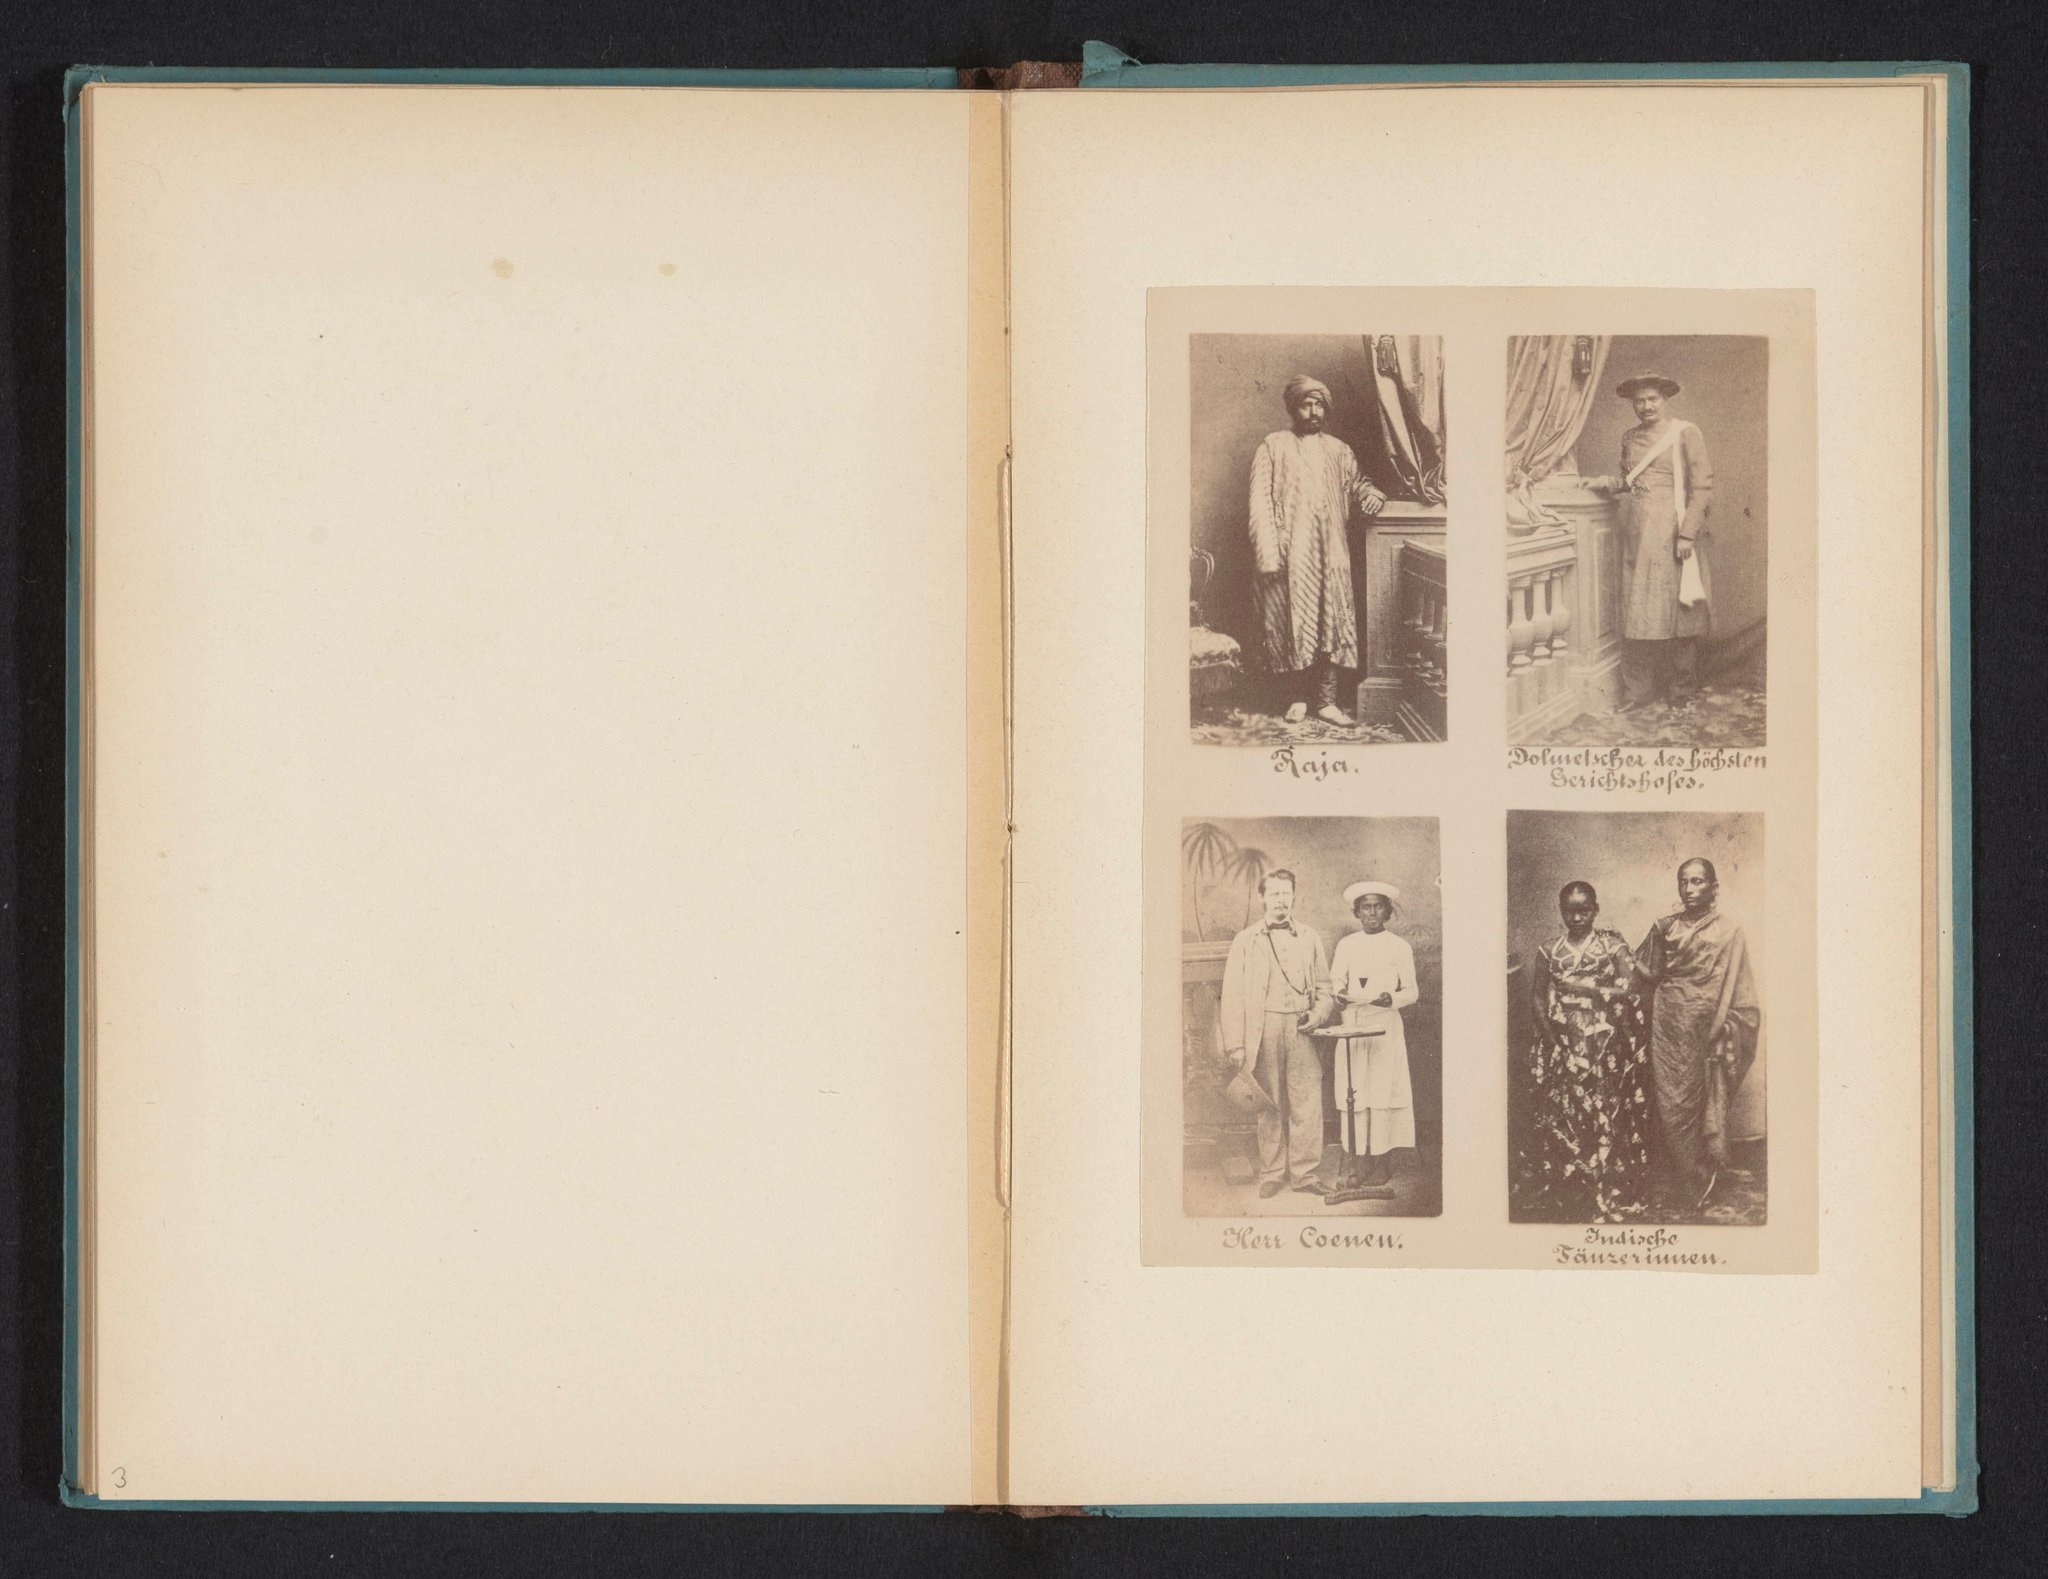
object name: photograph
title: Vier portretten van een radja, een tolk, de heer Coenen met een onbekende vrouw, en twee Indiase danseressen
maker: Anonymous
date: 1884-1889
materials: photographic support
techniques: albumen print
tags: interpreter ~ language, female dancer, ruler, sovereign